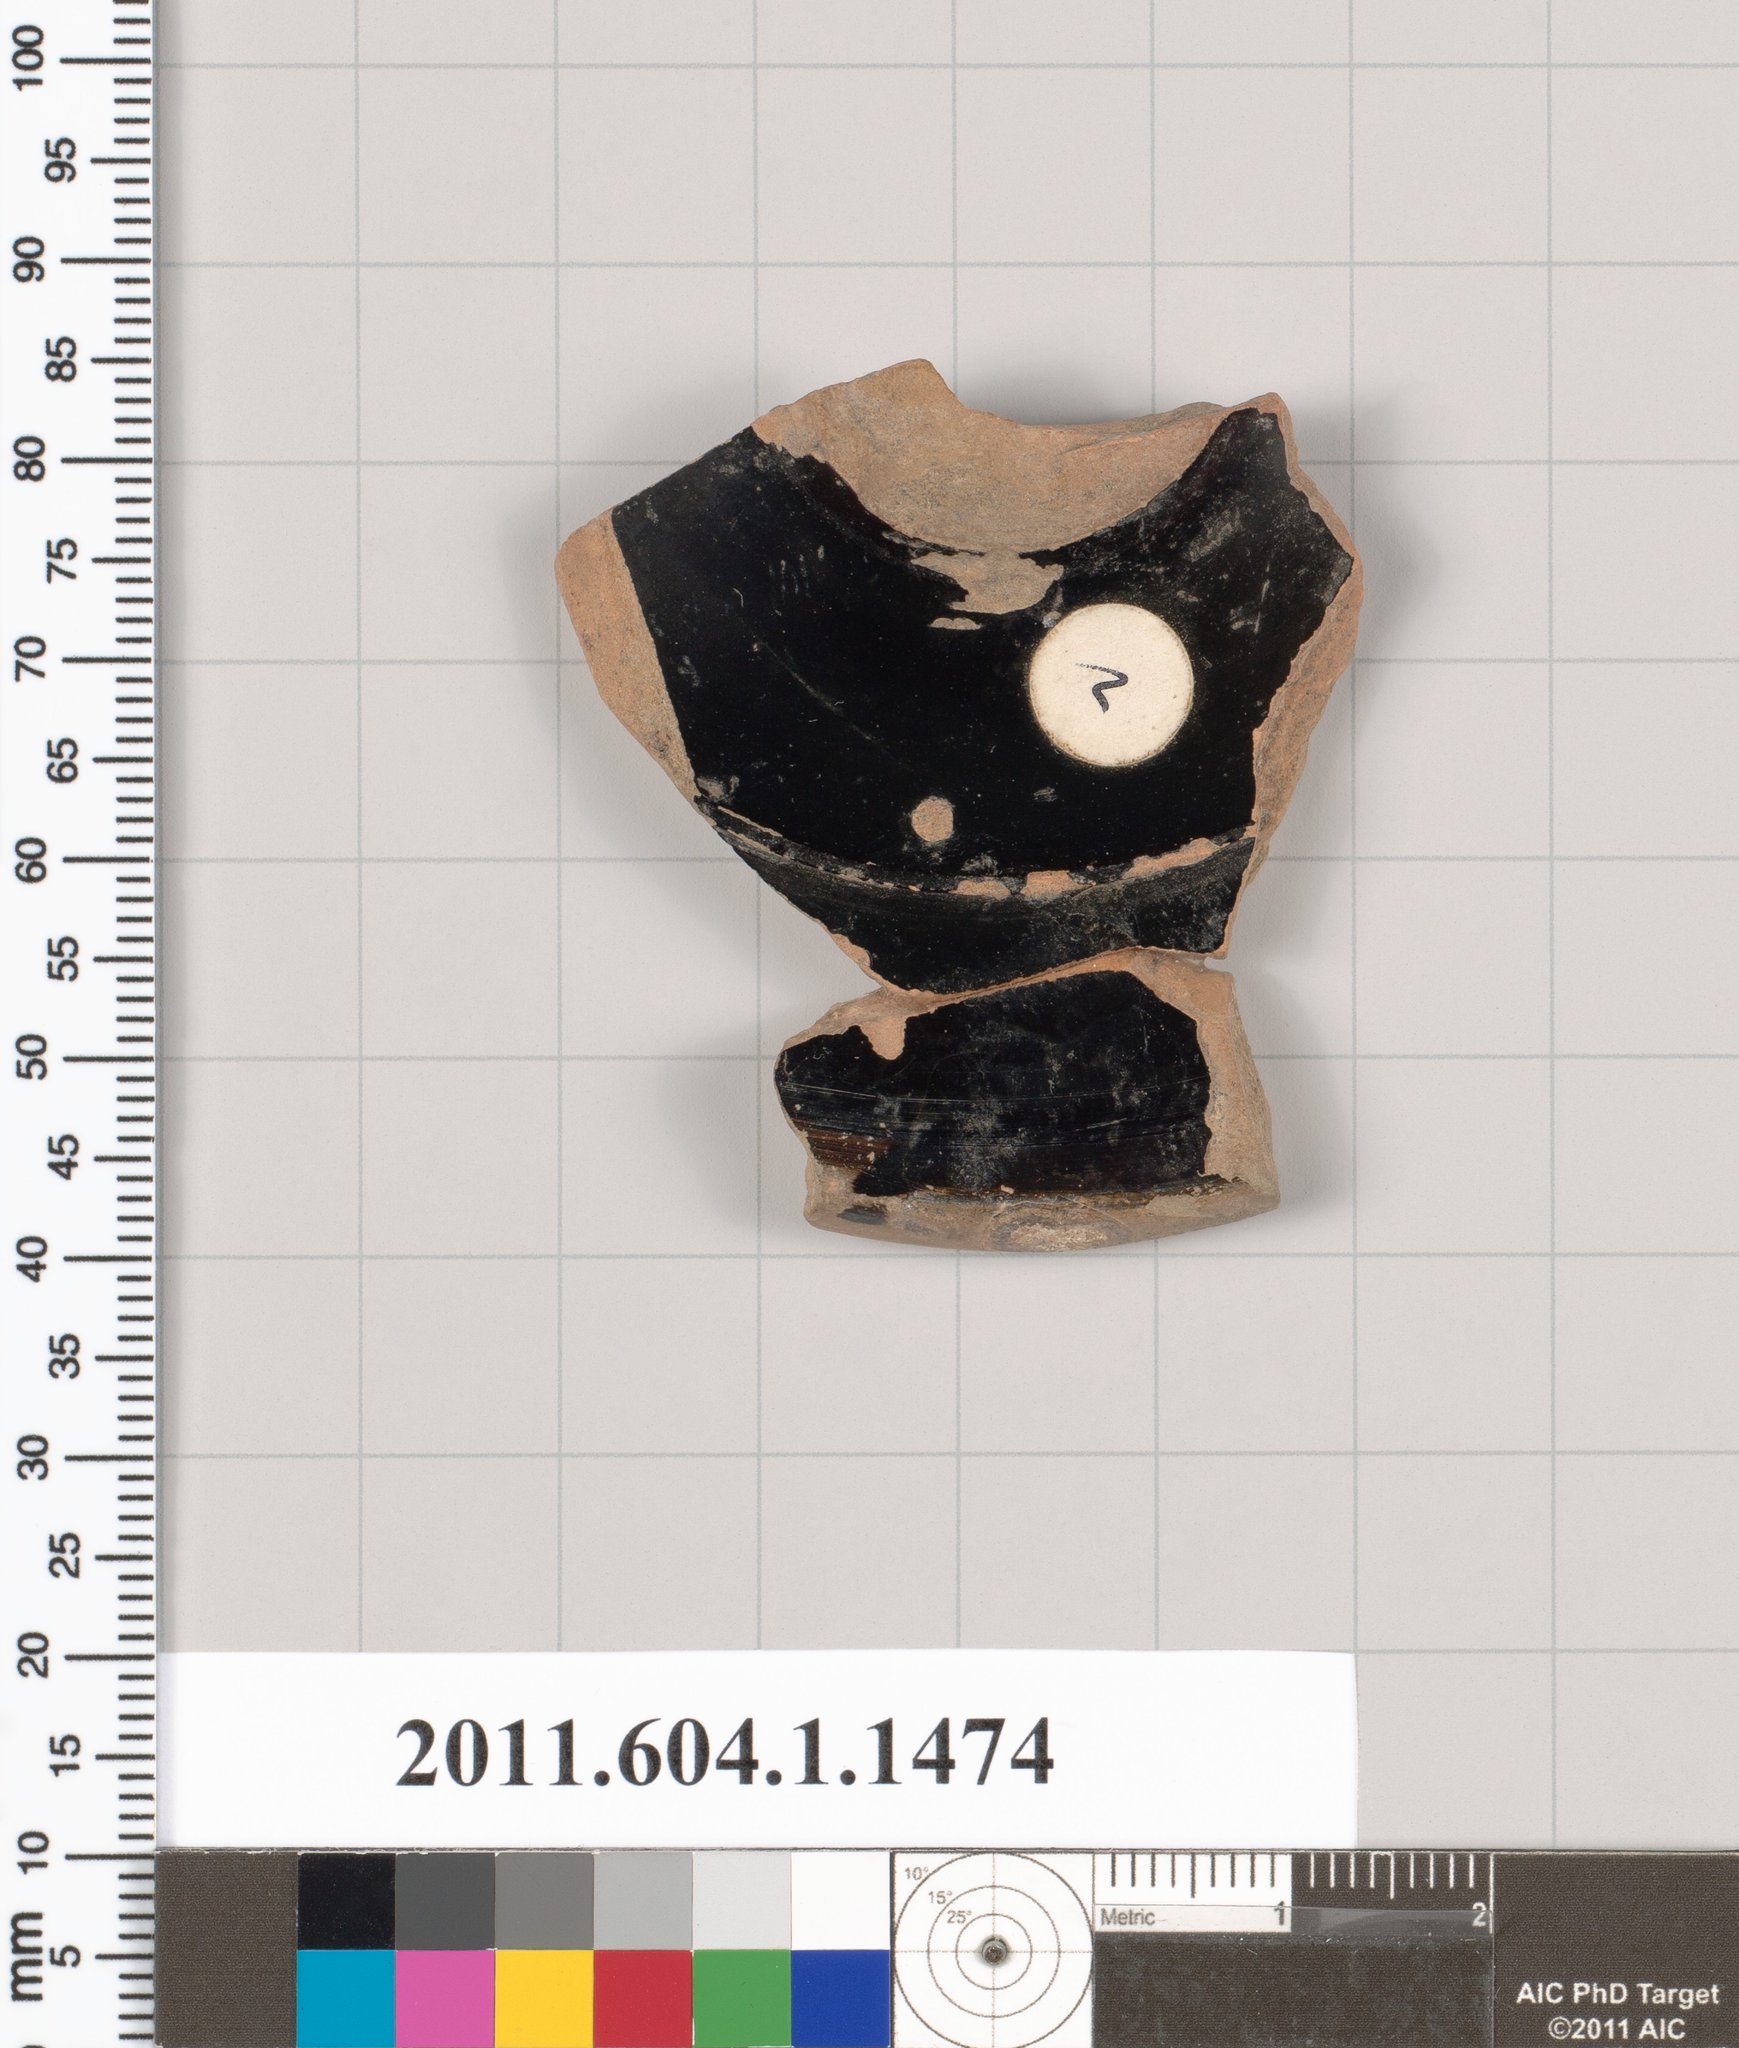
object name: kylix fragment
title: Terracotta fragment of a kylix (drinking cup)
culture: greek, attic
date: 500-401 BCE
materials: terracotta